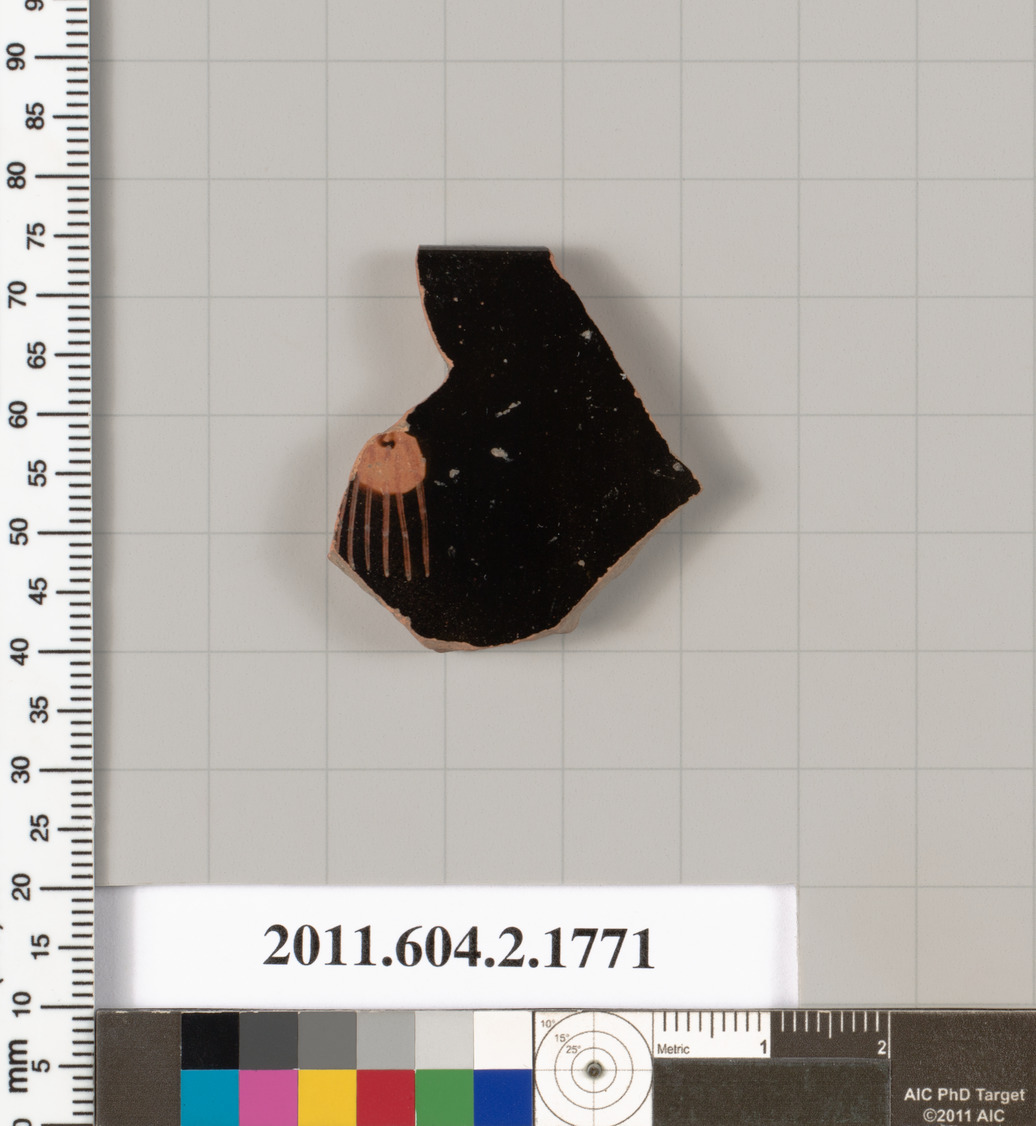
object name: skyphos fragment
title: Terracotta rim fragment of a skyphos (deep drinking cup)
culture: greek, attic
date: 460-450 BCE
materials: terracotta